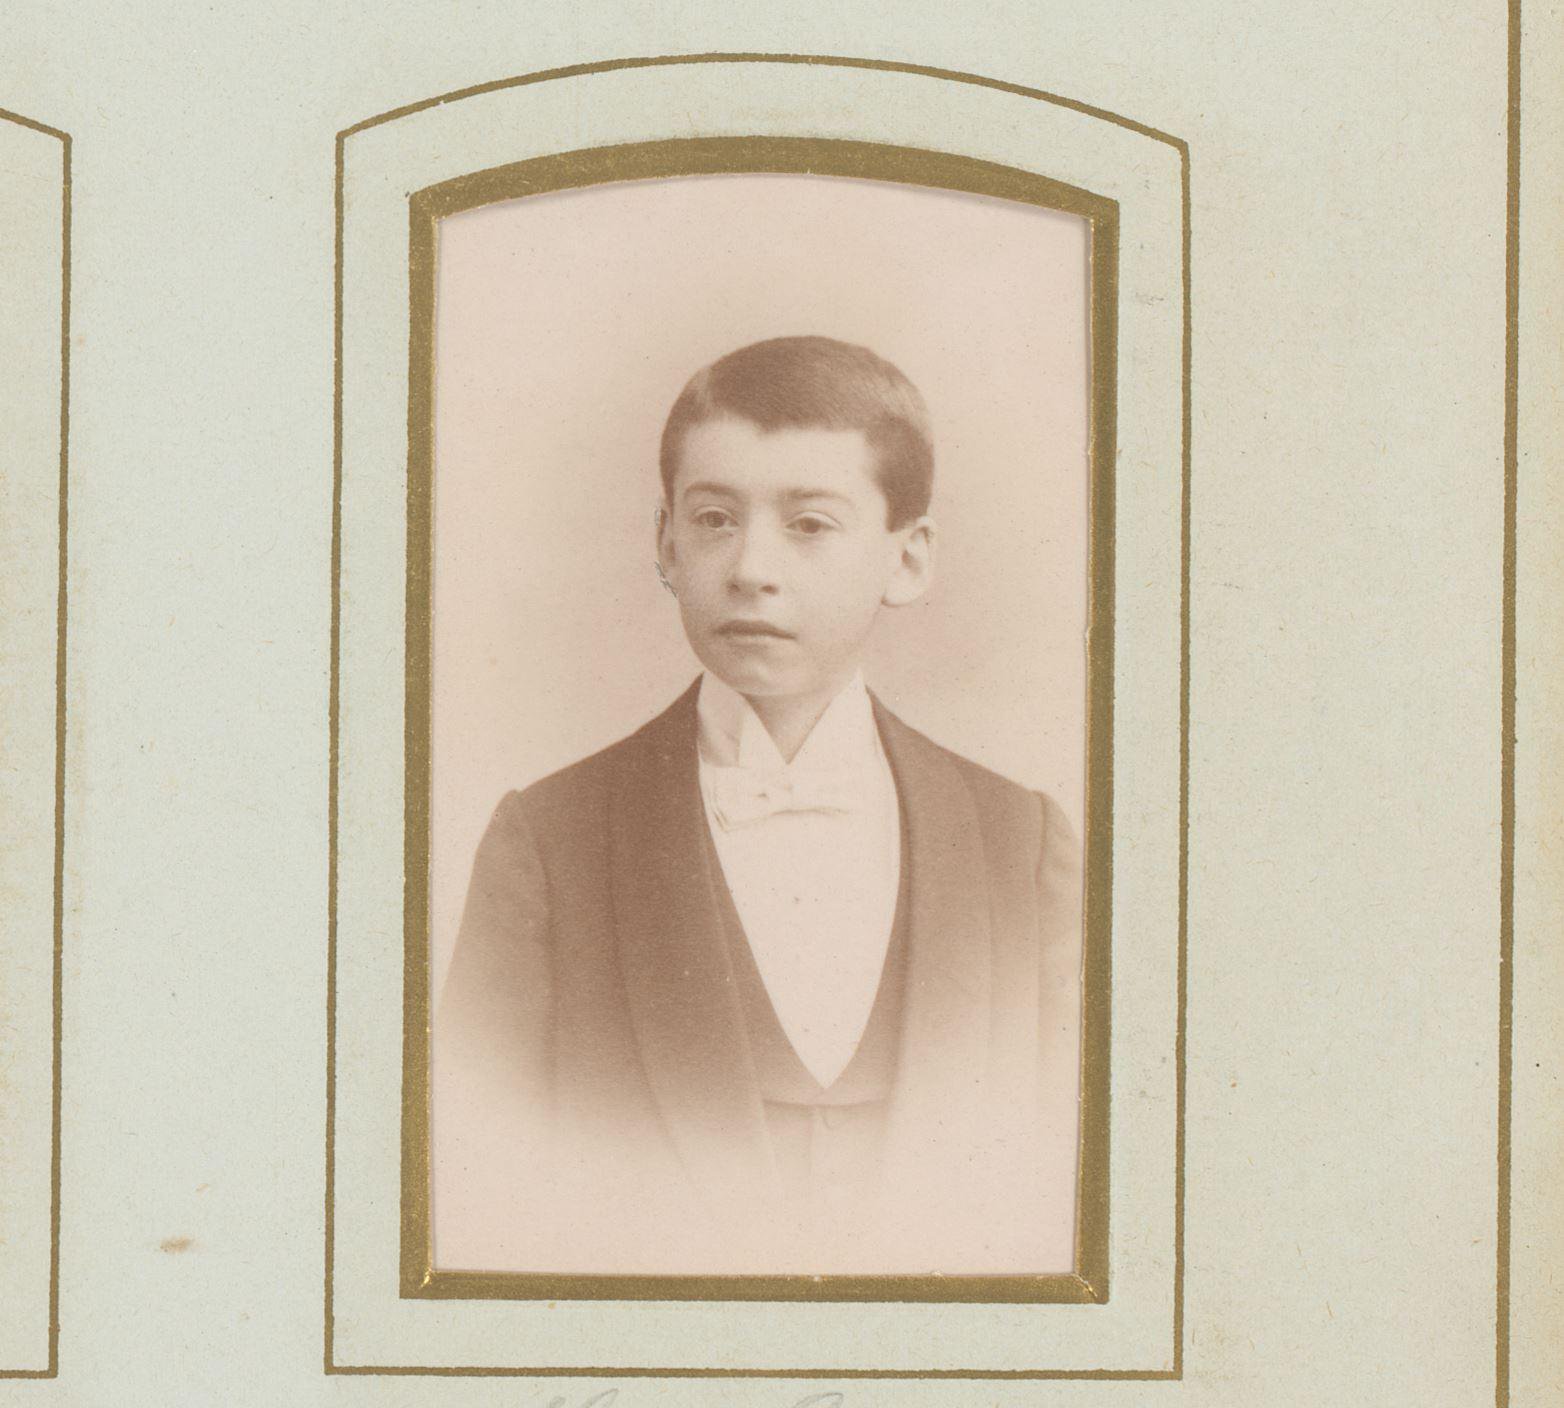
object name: album leaf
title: Portret van Henri Ernie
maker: louis larger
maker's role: fotograaf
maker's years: 1849-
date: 1880-1920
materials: cardboard, photographic support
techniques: collodion silver print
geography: paris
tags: boy (child between toddler and youth), historical persons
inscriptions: inscription: ‘Grand-Prix/ Plusieurs Fois Membre du Jury/ Hors Concours/ PHOTOTYPIE-HÉLIOTYPIE/ Impression Rapide aux Encres Grasses/ Ancne. Mon. JAMIN/ L. LARGER Sr./ 13, Rue Chapon, 13/ PARIS’, name: ‘Henri Ernie +1915’